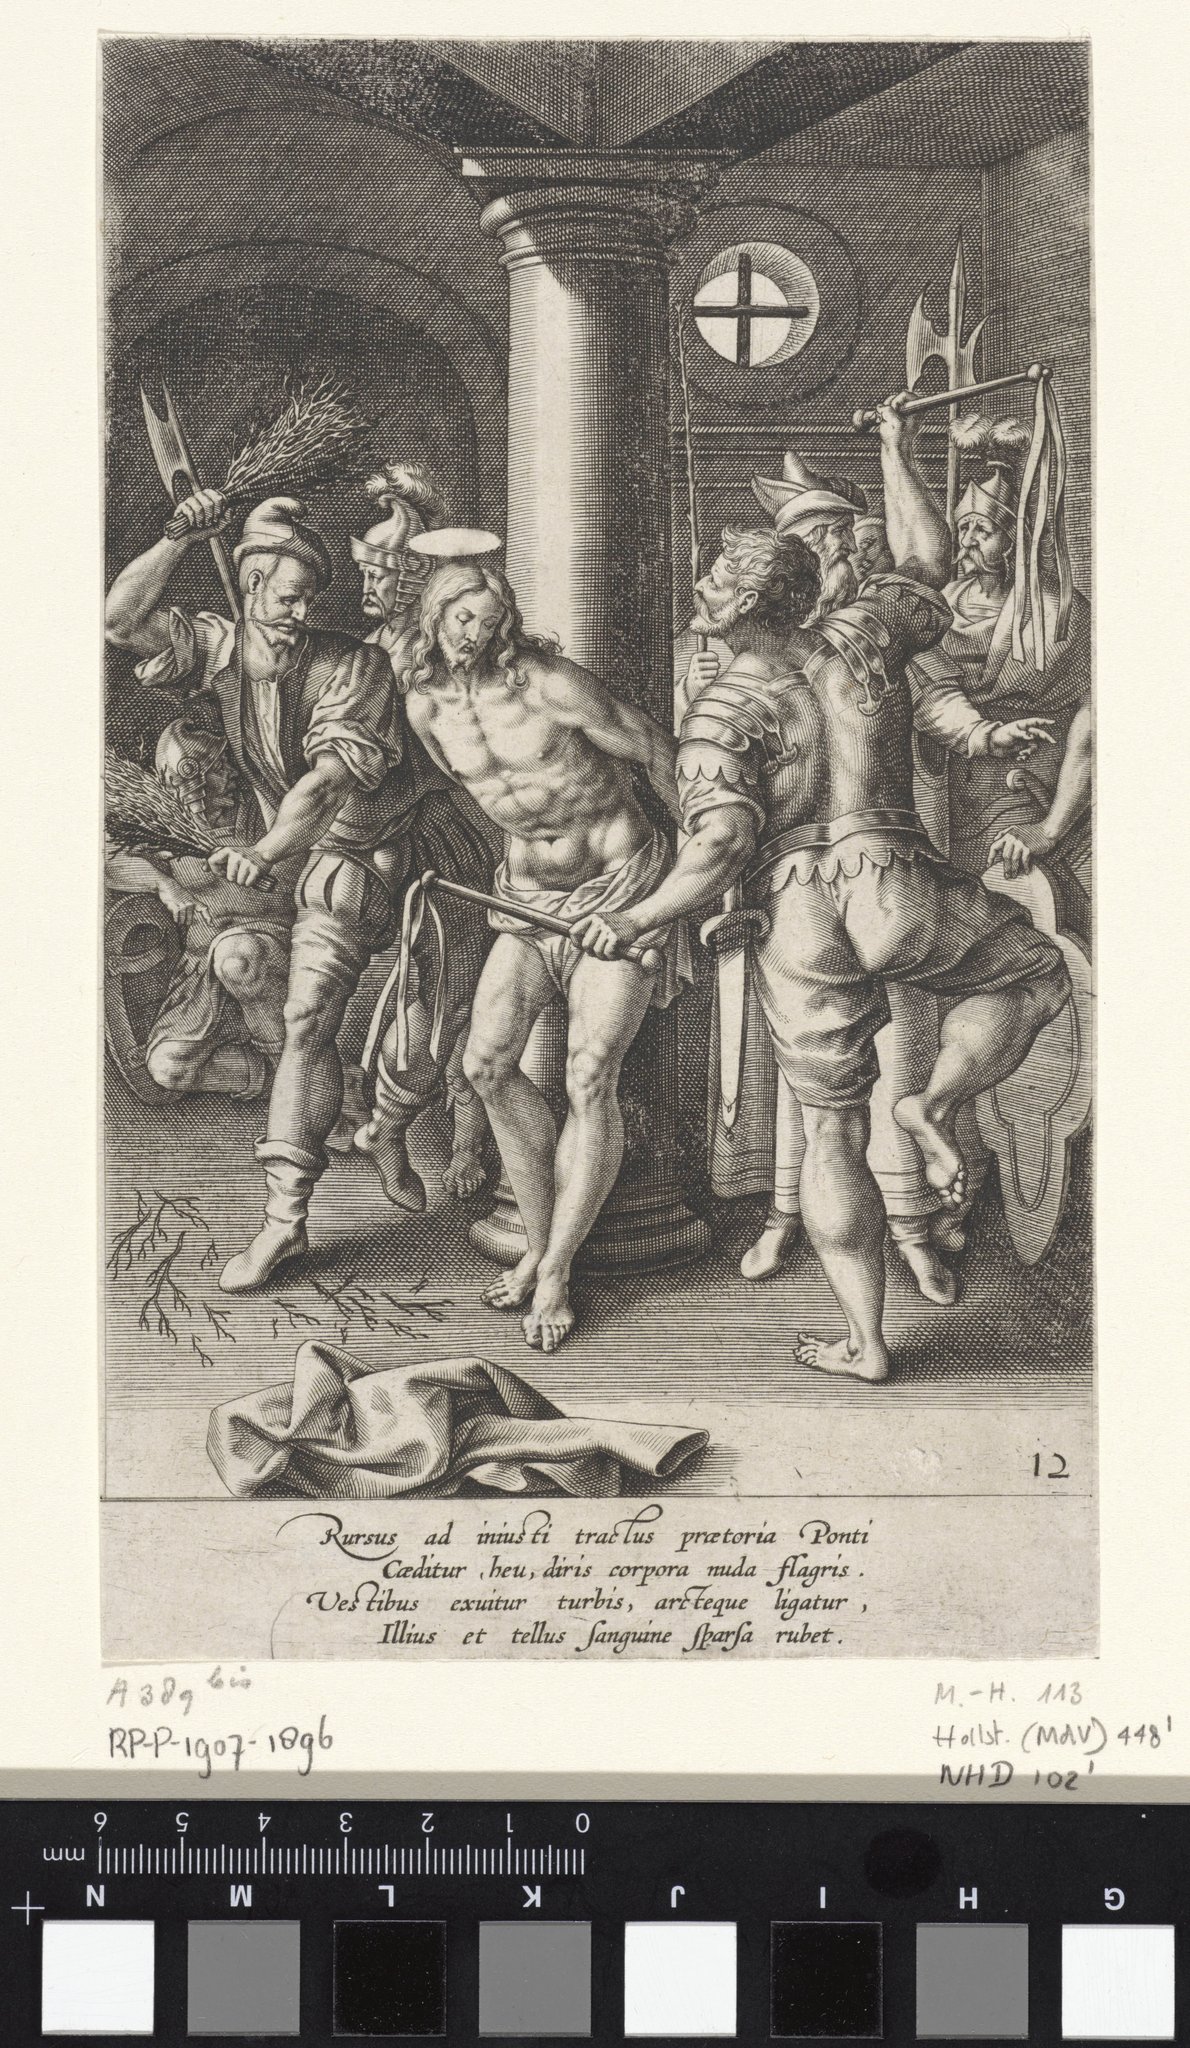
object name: print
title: Dominicæ Passionis Mysteria Typicis Advmbrationibvs Adamussim Effigiata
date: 1583-1587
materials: paper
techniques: engraving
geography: antwerp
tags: flagellation by soldiers, christ usually tied to a column (matthew 27:26; mark 15:15; john 19:1)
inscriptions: collector's mark: Lugt 2228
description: Prent gebruikt in: Thesaurus sacrarum historiaru[m] veteris (et novi) testame[n]ti, elega[n]tissimis imaginibus expressu[m] excelle[n]tissimoru[m] in hac arte viroru[m] opera : nu[n]c primu[m] in luce[m] editus. Antwerpen: Gerard de Jode, 1585.